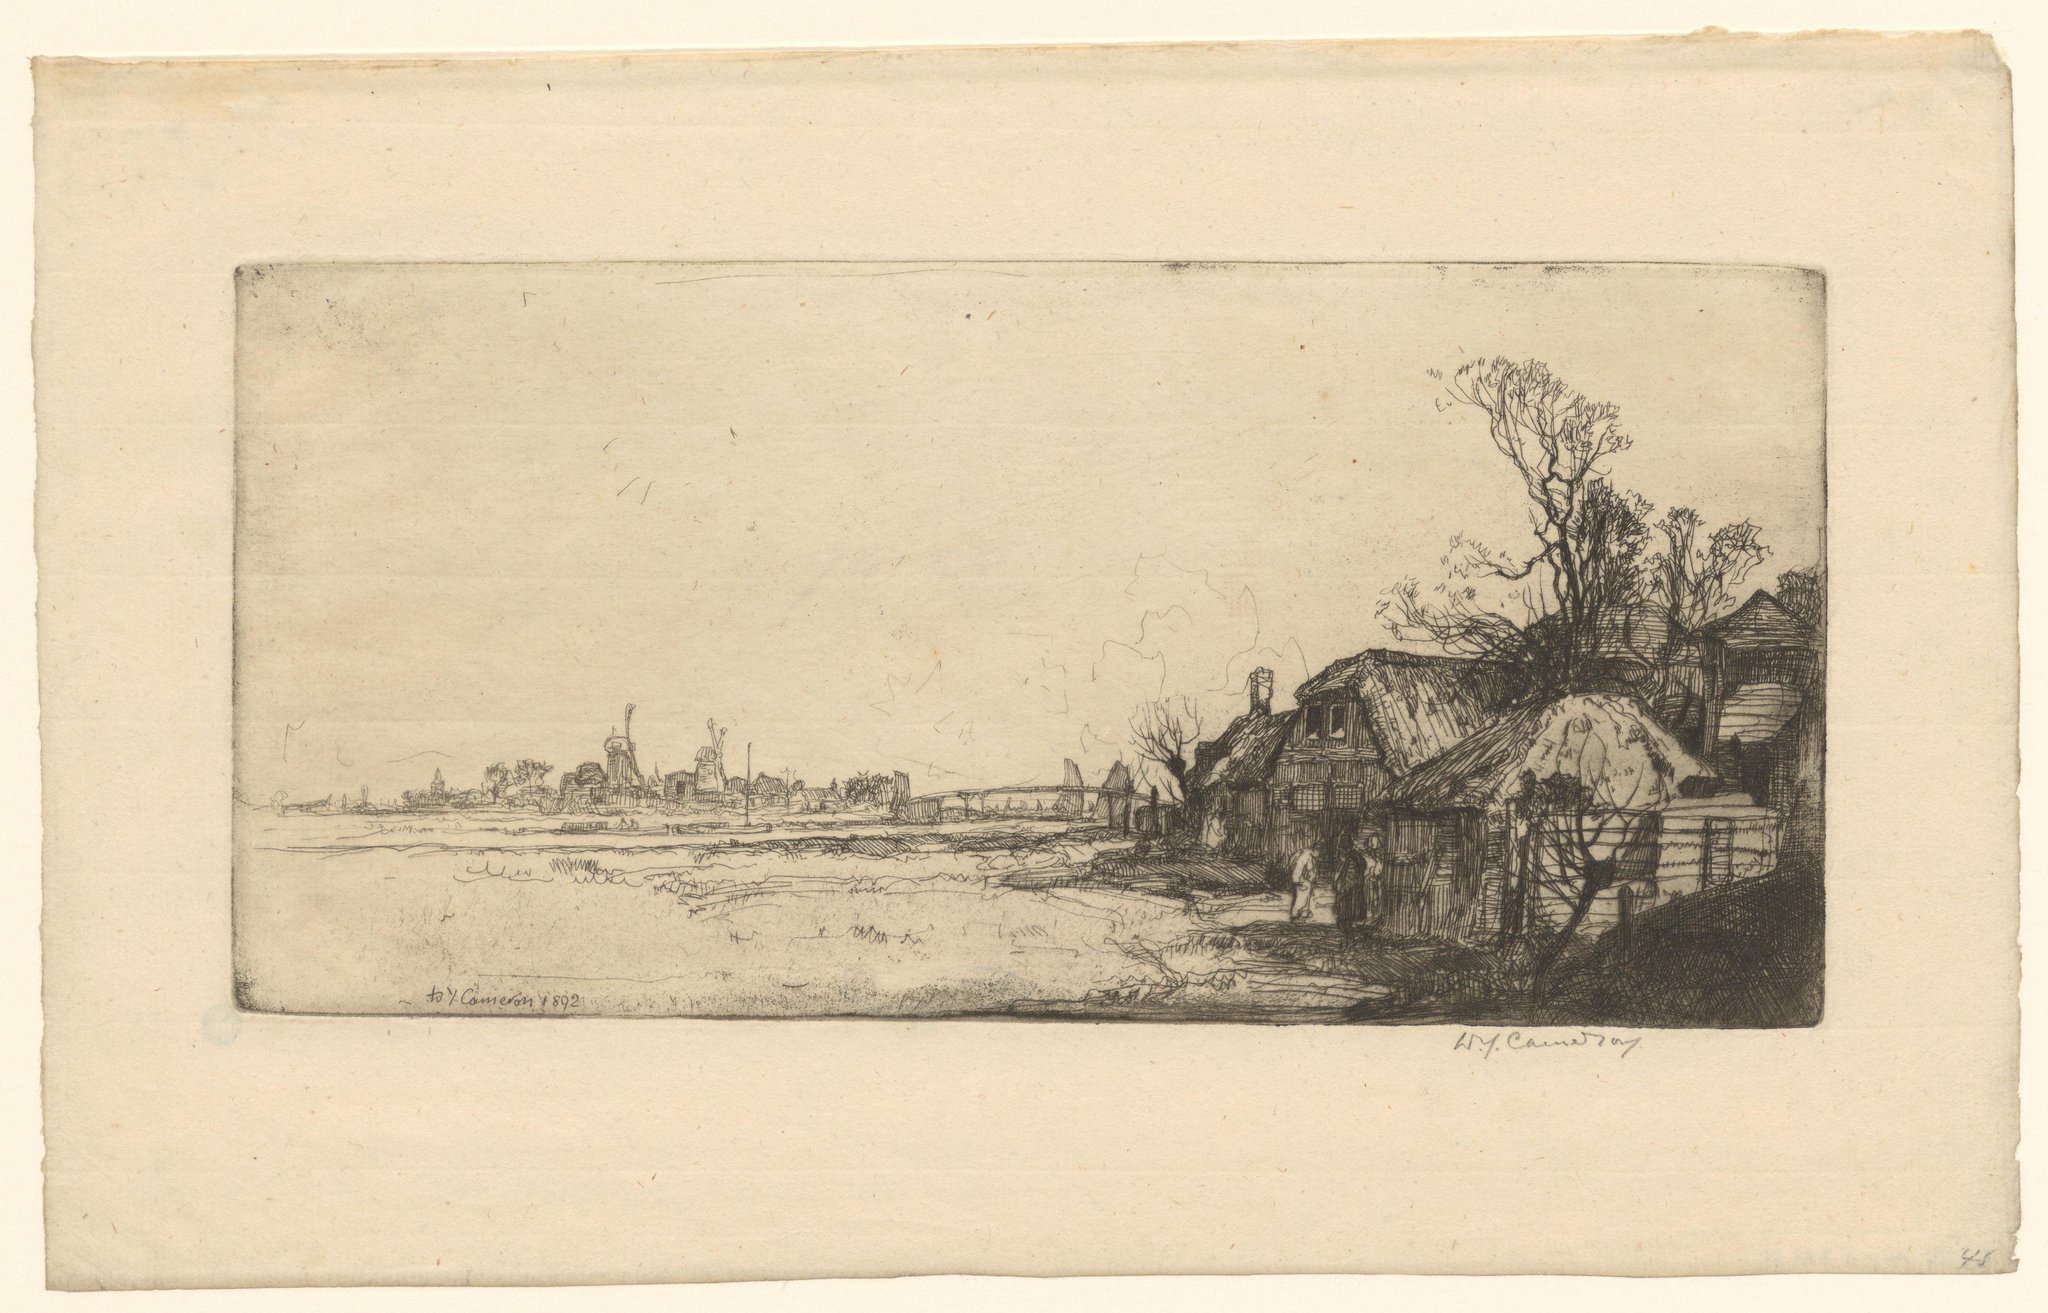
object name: print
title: A Rembrandt Farm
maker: david young cameron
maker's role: draughtsman, print maker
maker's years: 1865-1945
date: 1892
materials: paper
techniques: drypoint, etching, intaglio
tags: windmill in landscape, farm or solitary house in landscape, haarlem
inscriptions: collector's mark: Lugt 2228, collector's mark: Lugt 872b, collector's mark: Lugt 2760